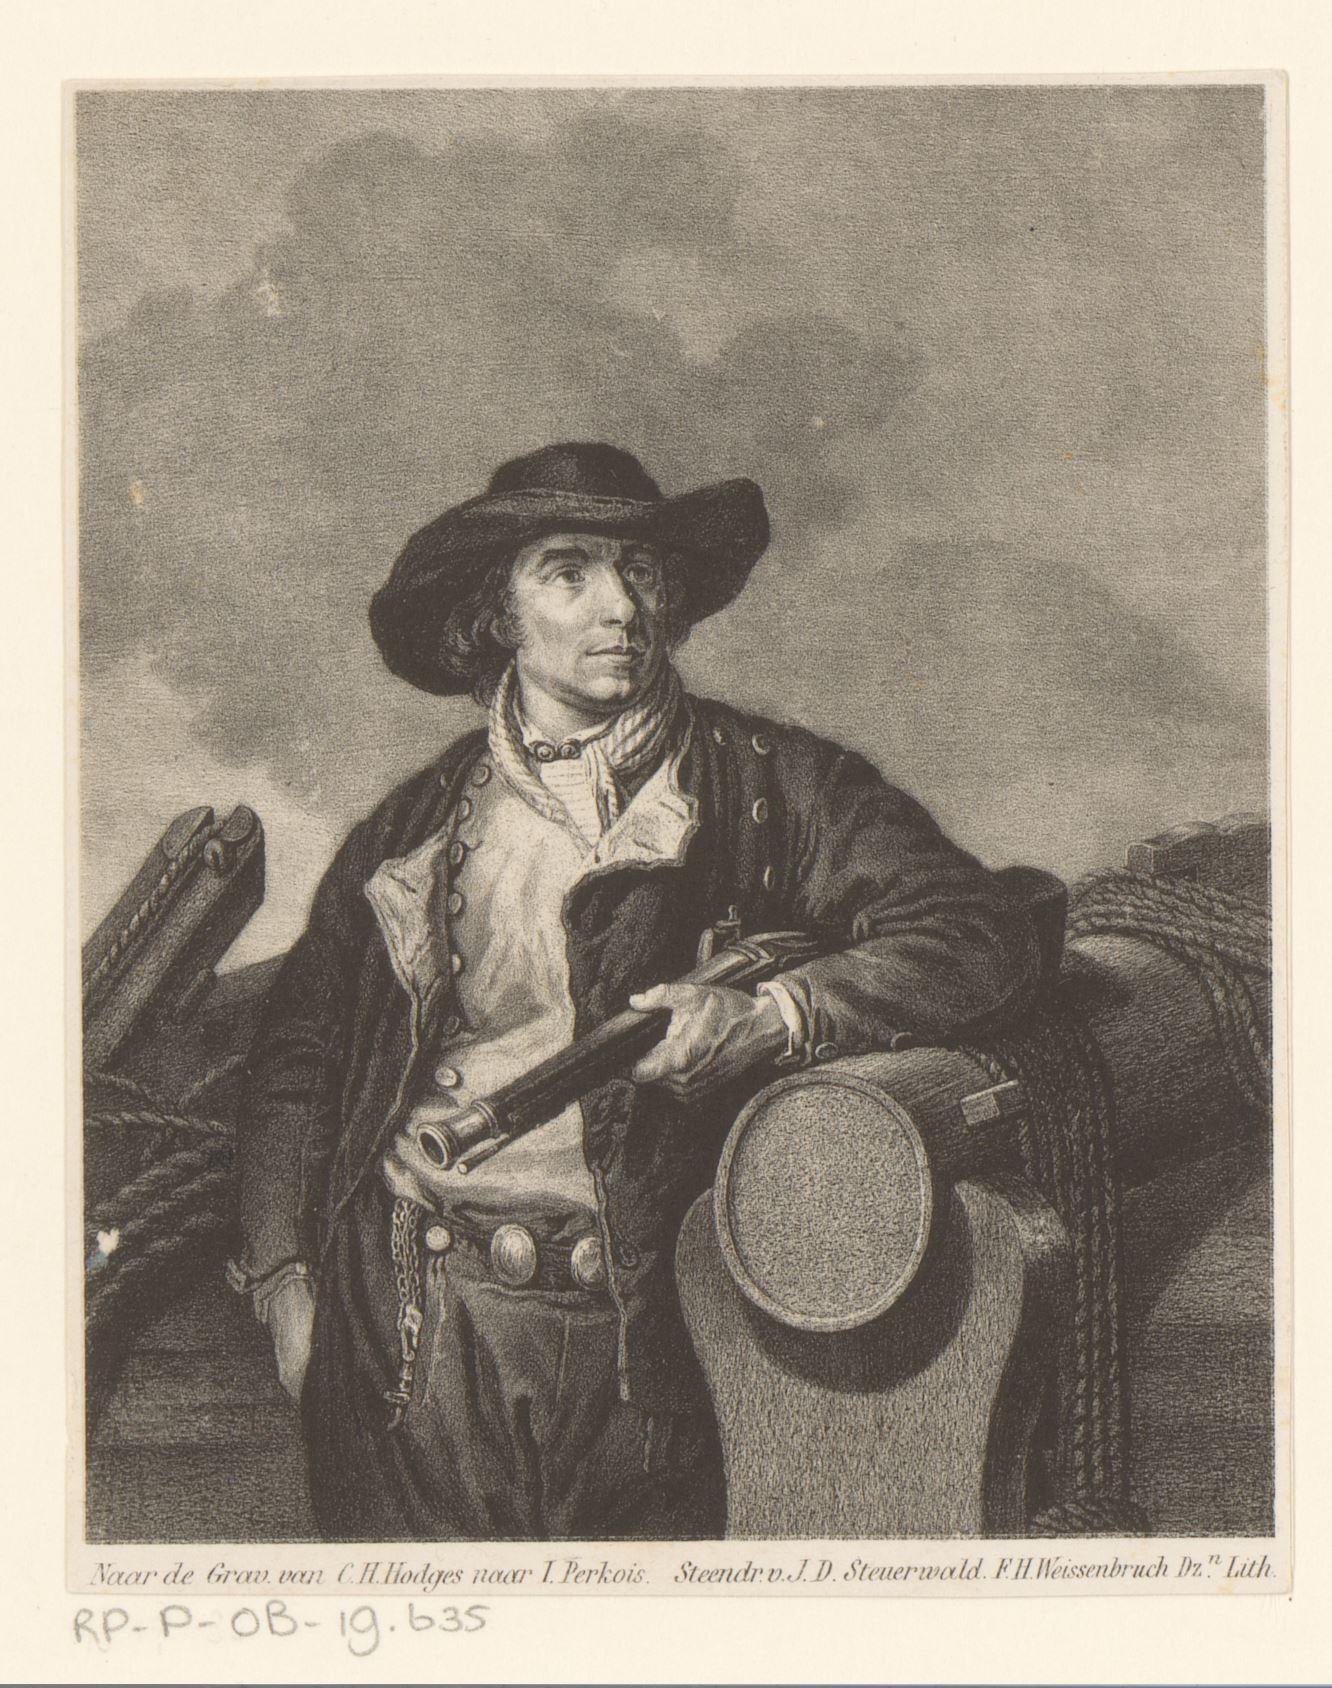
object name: print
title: Portret van Wiert Adels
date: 1858-1862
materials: paper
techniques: lithograph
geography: the hague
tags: historical persons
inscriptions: collector's mark: Lugt 2228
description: Prent uit: Jonge, J.C. de. Geschiedenis van het Nederlandsche zeewezen. Haarlem: Jonge, J.K.J. de, 1858-62.